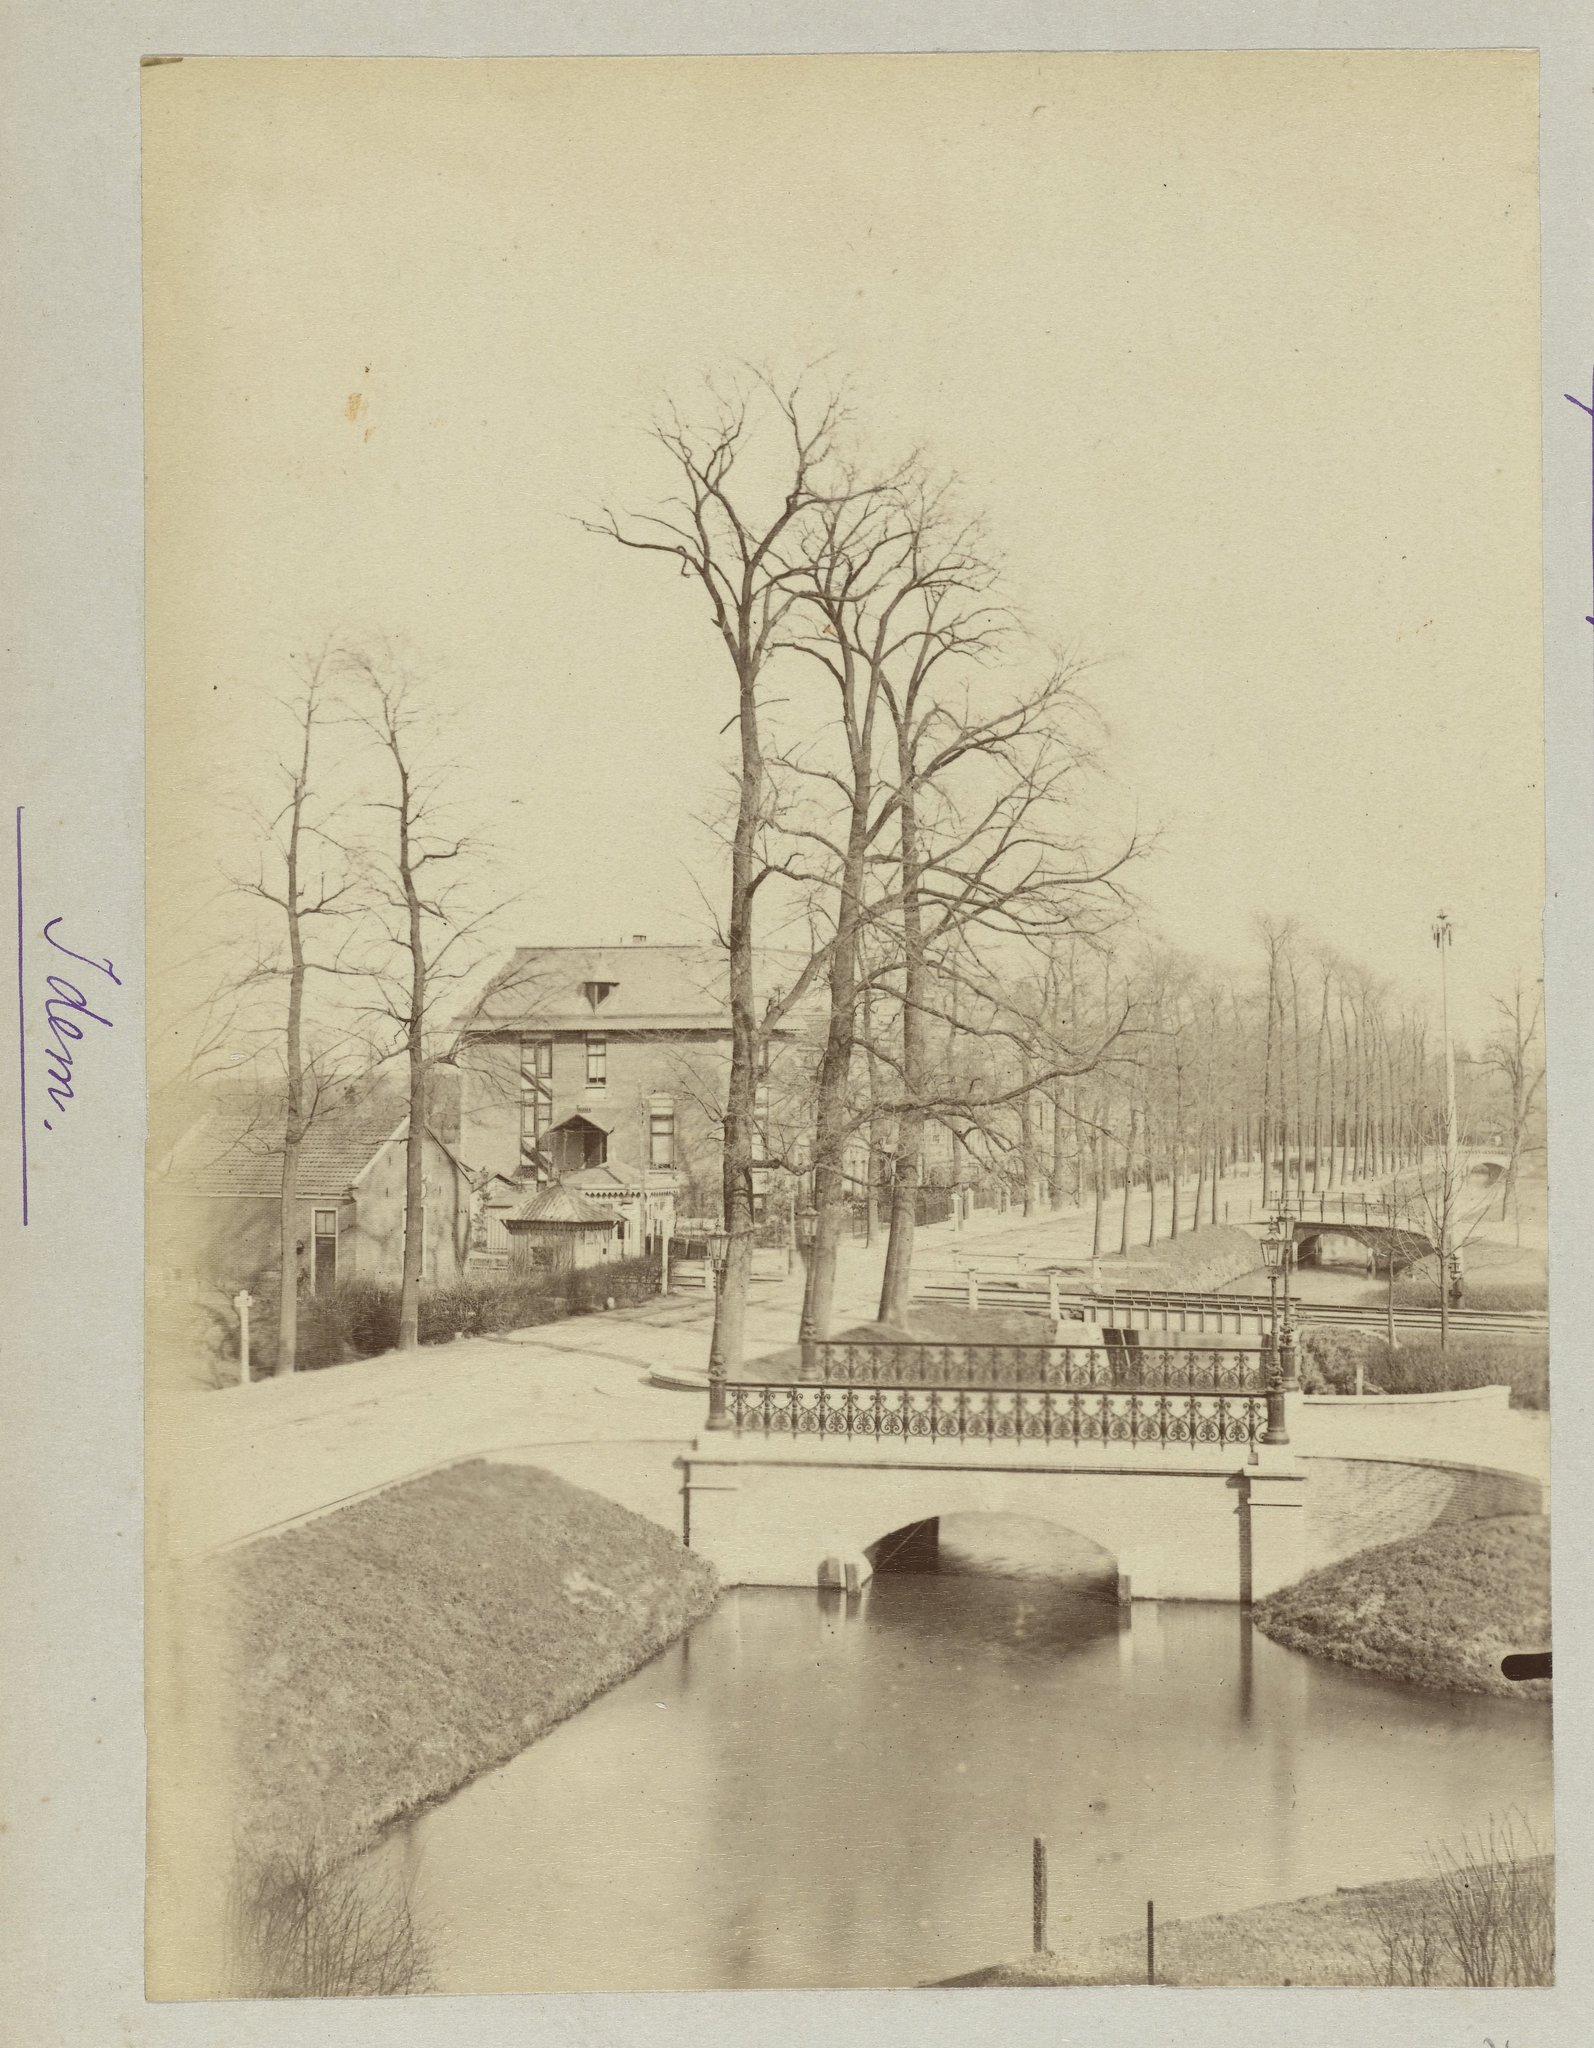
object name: photograph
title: Zicht op de Biltstraat vanuit herenhuis De Oorsprong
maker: henry pauw van wieldrecht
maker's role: fotograaf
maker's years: 1863-1912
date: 1888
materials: paper, photographic support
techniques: albumen print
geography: netherlands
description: Zicht op de vrijwel onbebouwde Biltstraat vanuit Herenhuis De Oorsprong. Links op het albumblad geschreven: Gezicht op de Biltstraat van De Oorsprong.